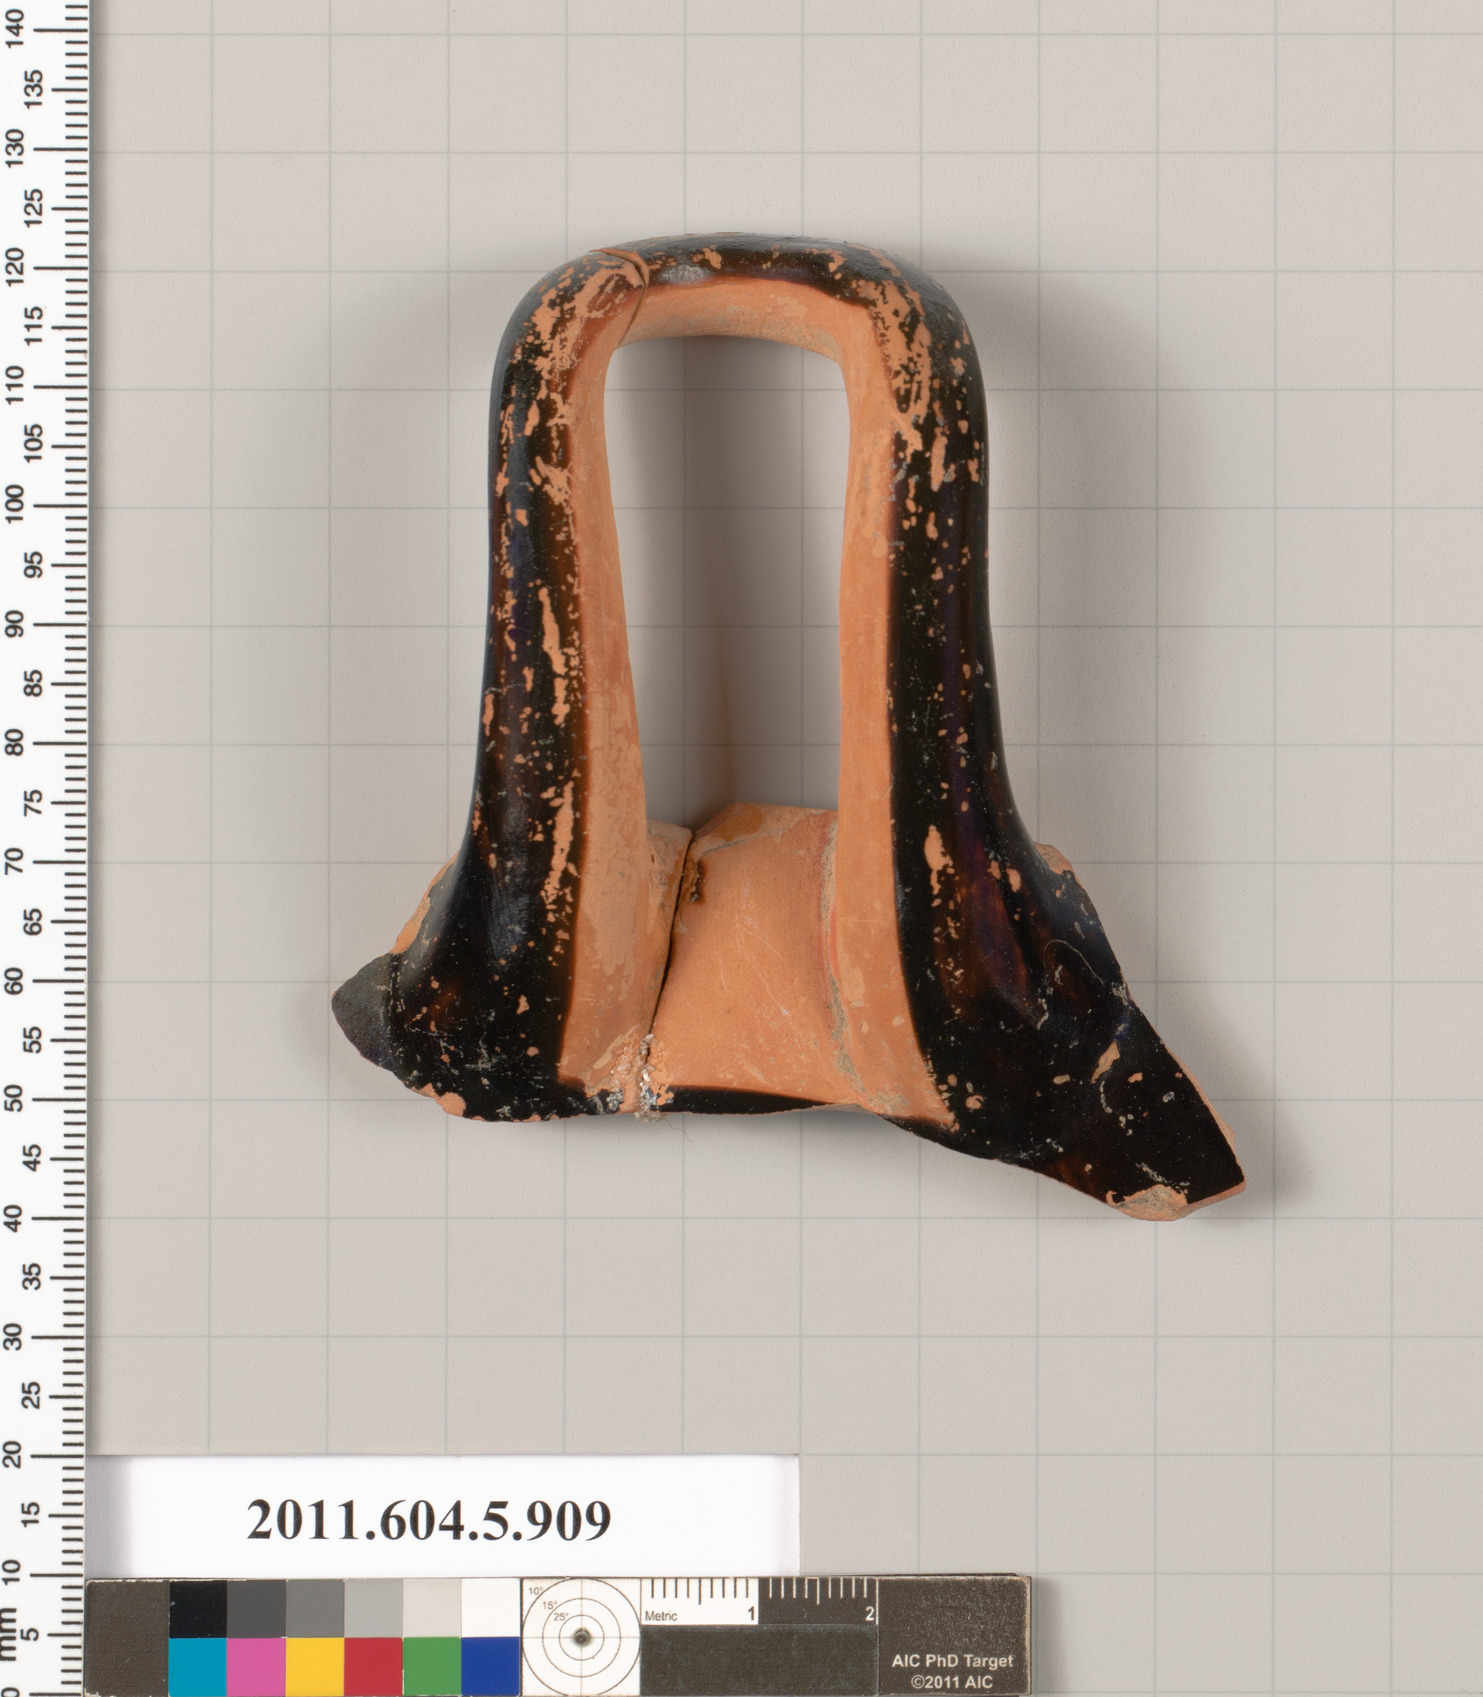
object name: kylix fragment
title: Terracotta fragment of a kylix (drinking cup)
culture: greek, attic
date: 600-401 BCE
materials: terracotta